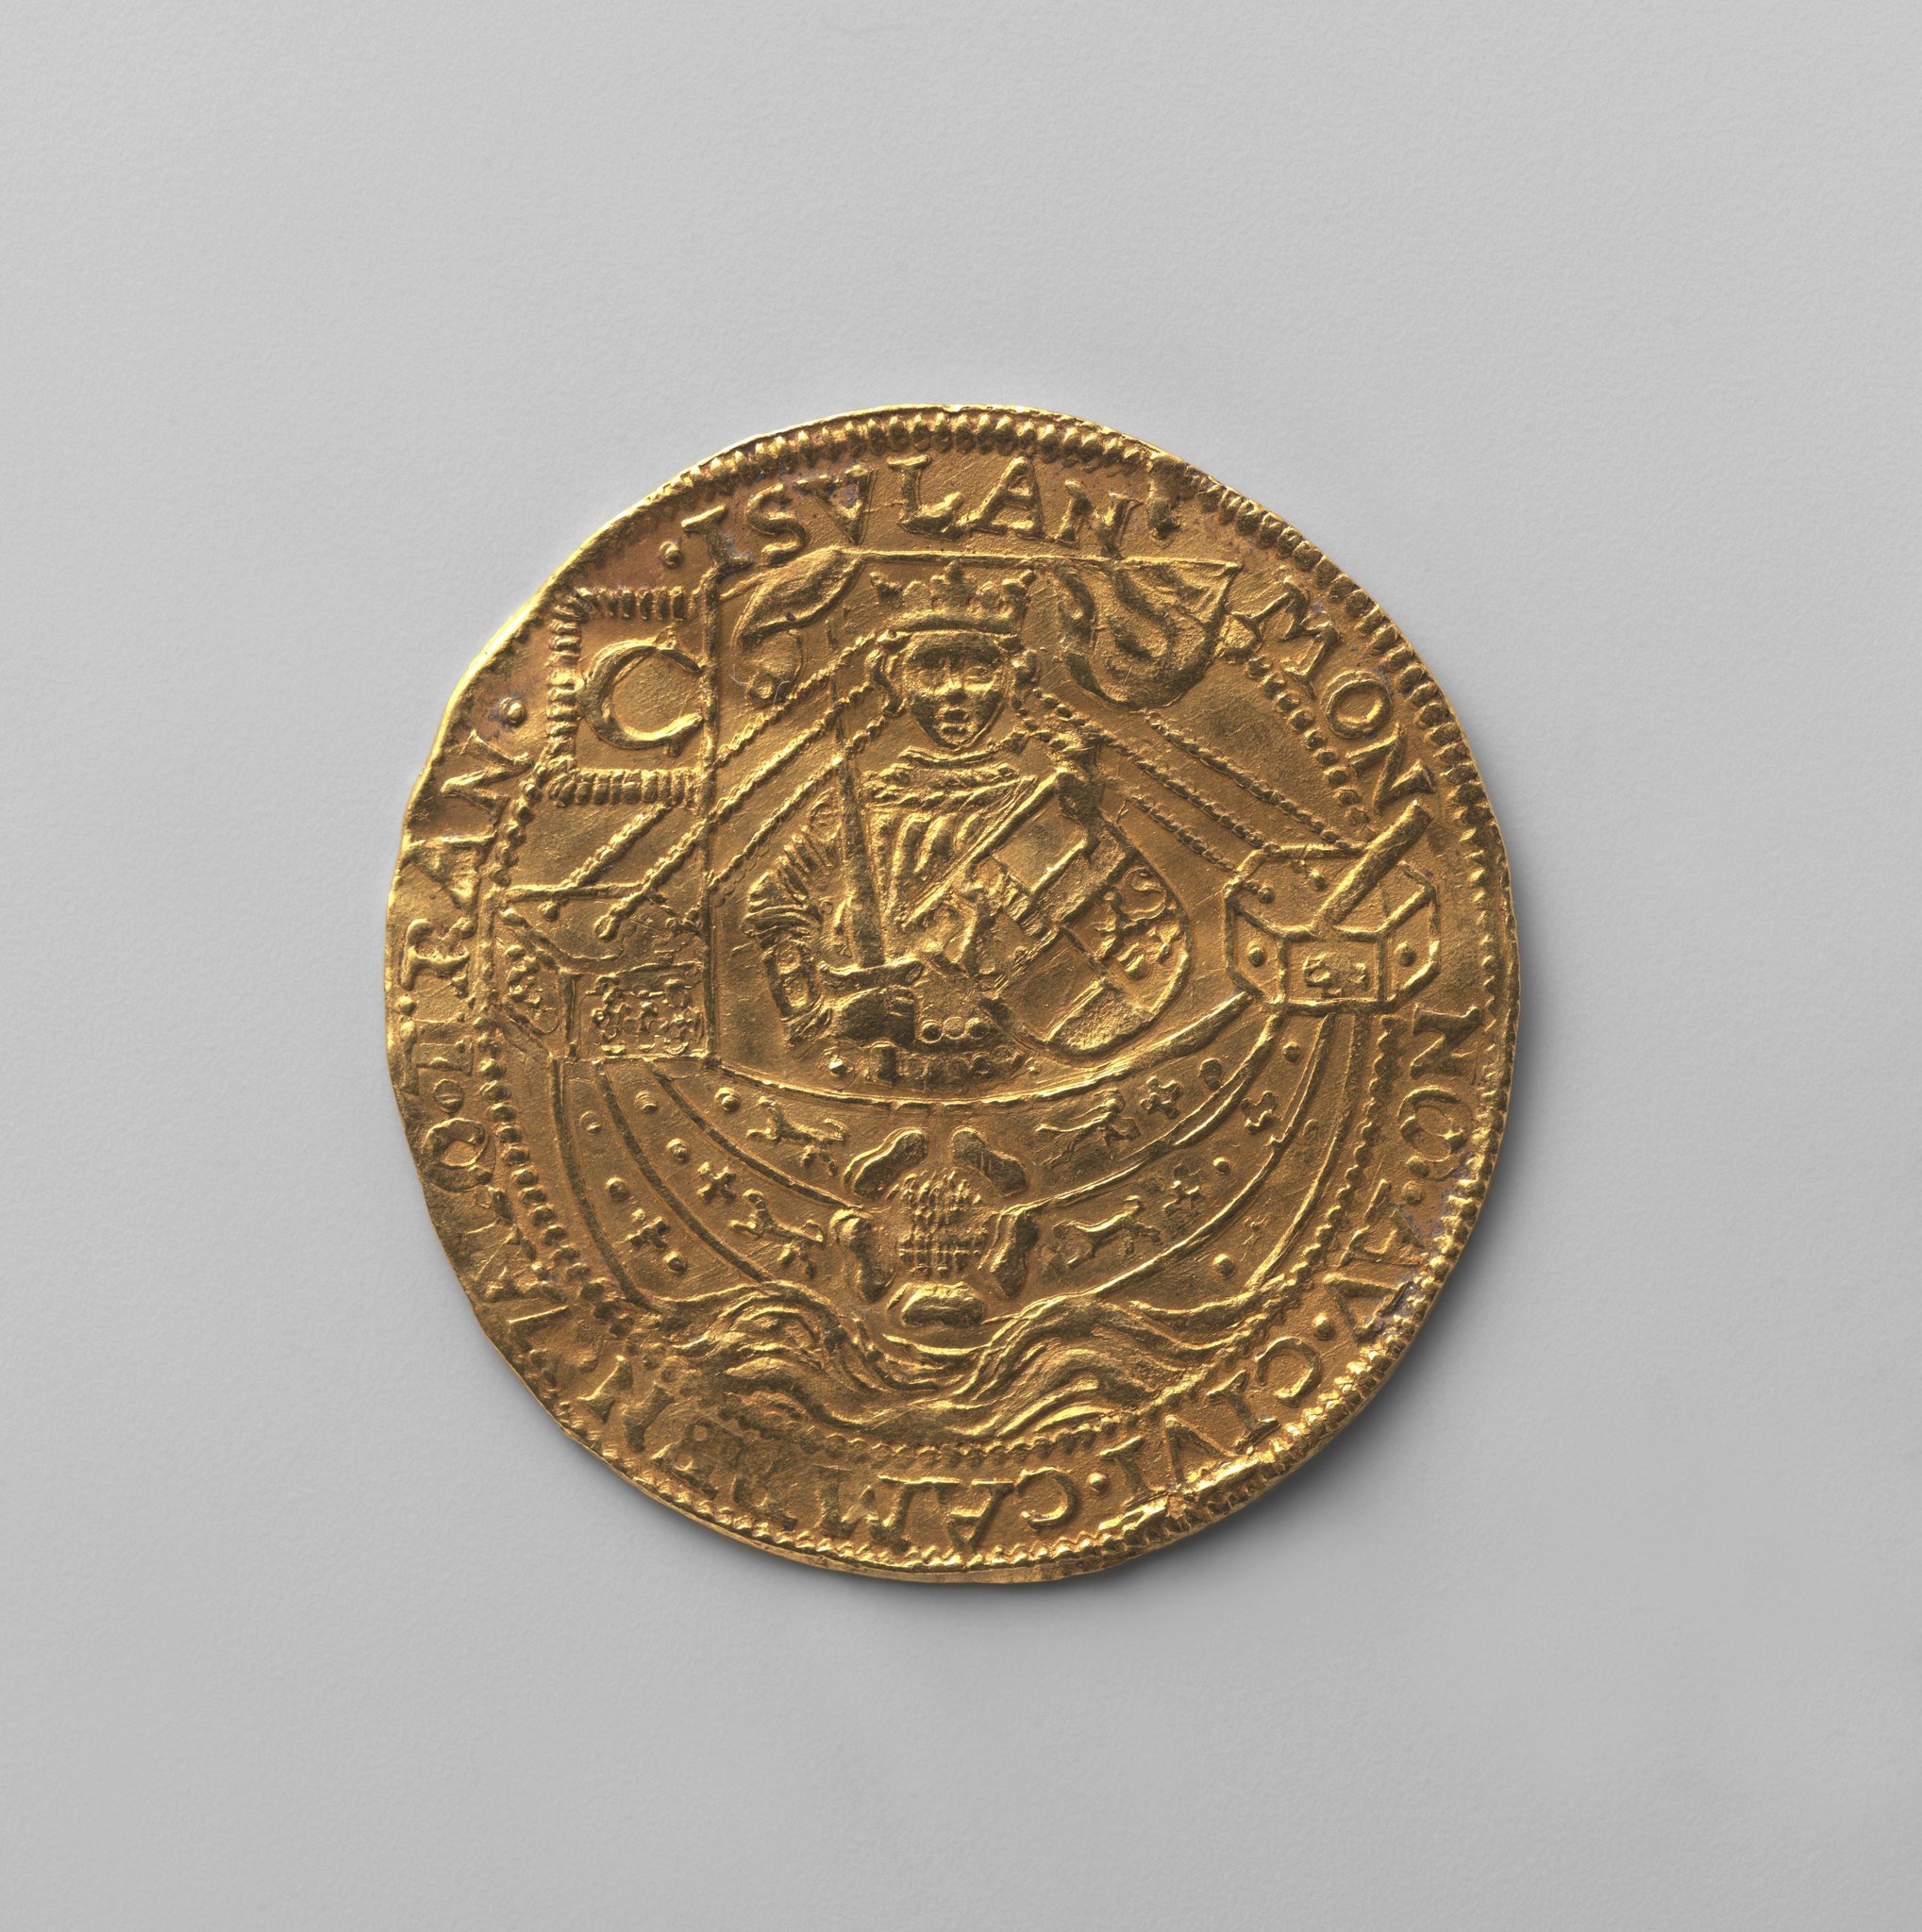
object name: coin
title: Kampen, rozenobel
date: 1590-1610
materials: gold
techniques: striking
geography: kampen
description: Gouden munt. Voorzijde: gekroonde staande vorst met in rechterhand zwaard en in linkerhand wapenschild, staande in een schip. Midden op scheepswand een roos en op achtersteven staande vlag, waarin letter C. Keerzijde: binnen dubbellijnige veelpas kort rijk versierd kruis met in het centrum roos, waaruit zonnestralen en in de hoeken gekroonde dieren (leeuwen/luipaarden).